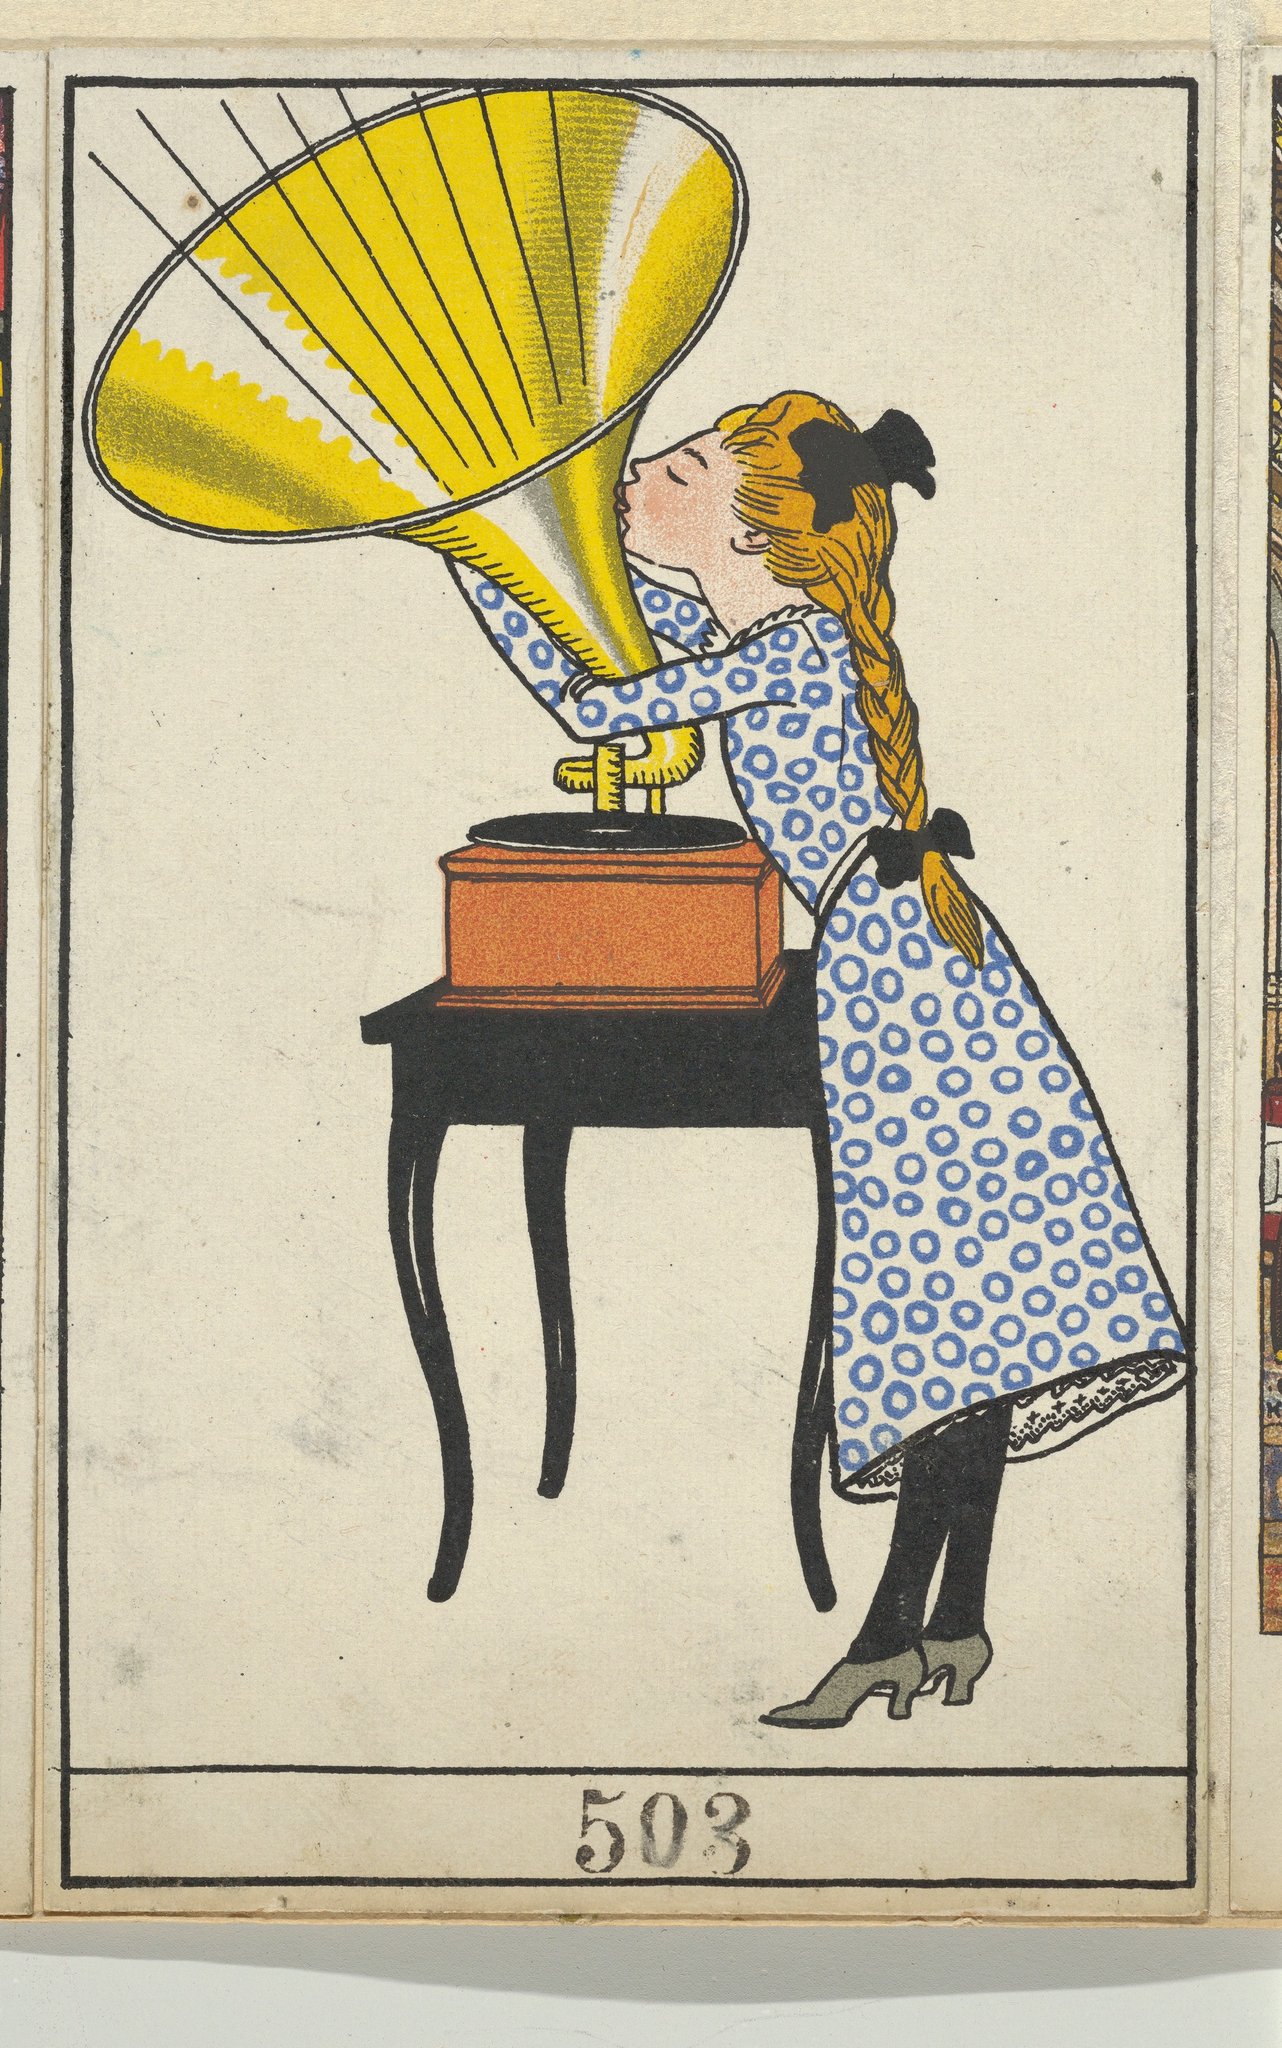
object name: print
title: O, Caruso!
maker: moriz jung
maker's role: artist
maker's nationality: austrian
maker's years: 1885-1915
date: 1911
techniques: lithograph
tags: women